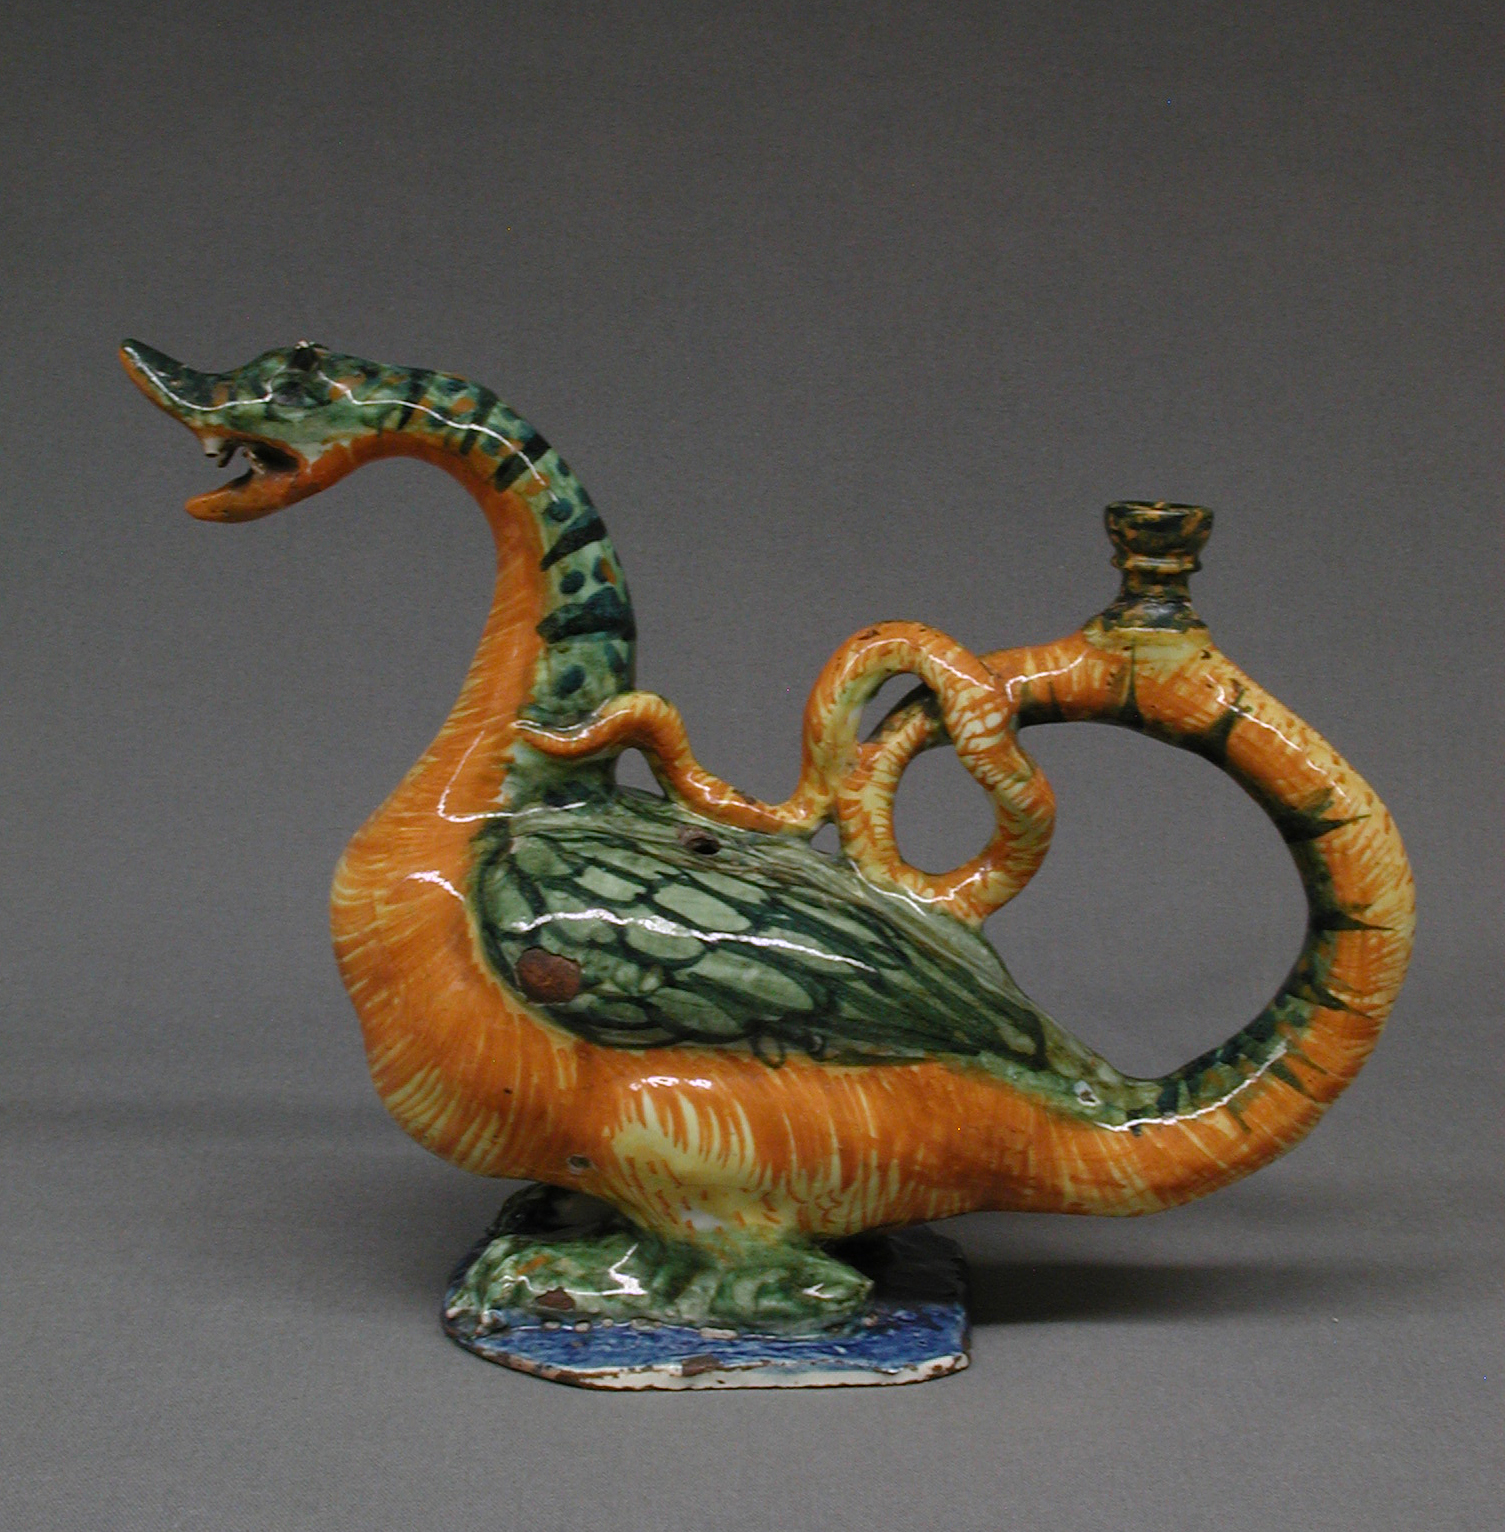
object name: figure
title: Dragon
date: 1550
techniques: maiolica, glazing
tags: dragons